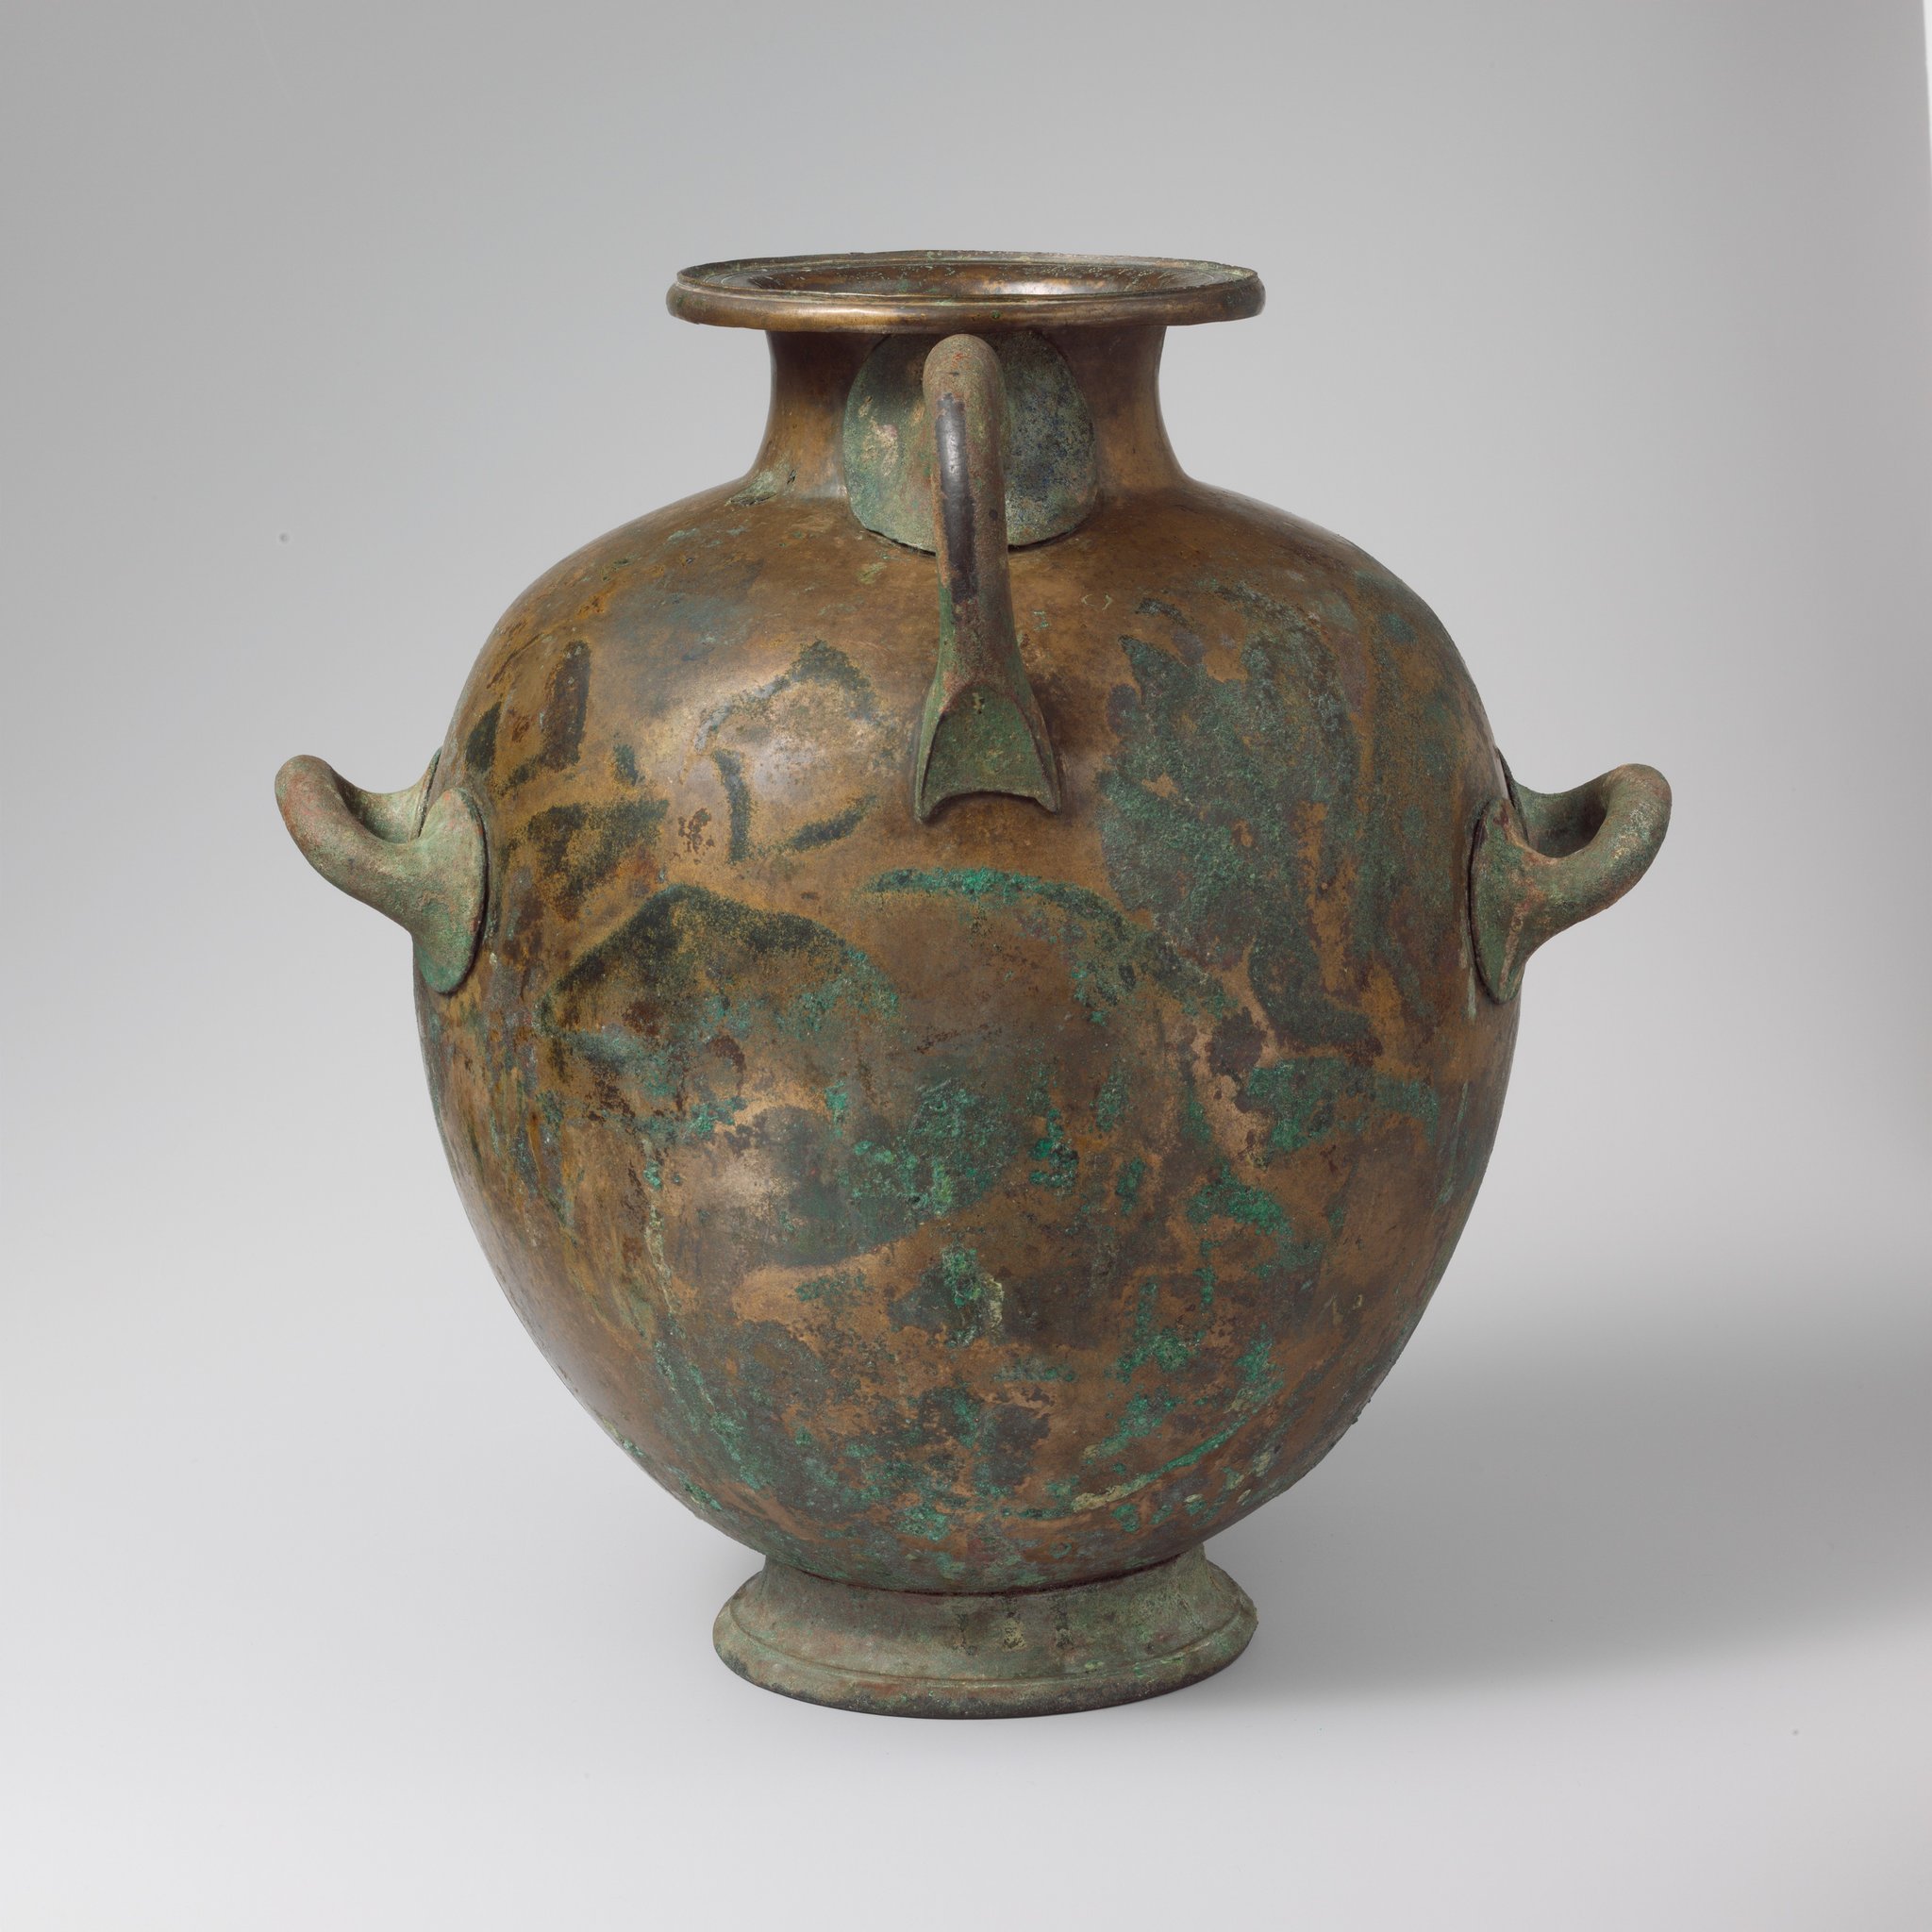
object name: hydria, kalpis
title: Bronze hydria: kalpis (water jar)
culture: greek, attic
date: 500-468 BCE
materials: bronze